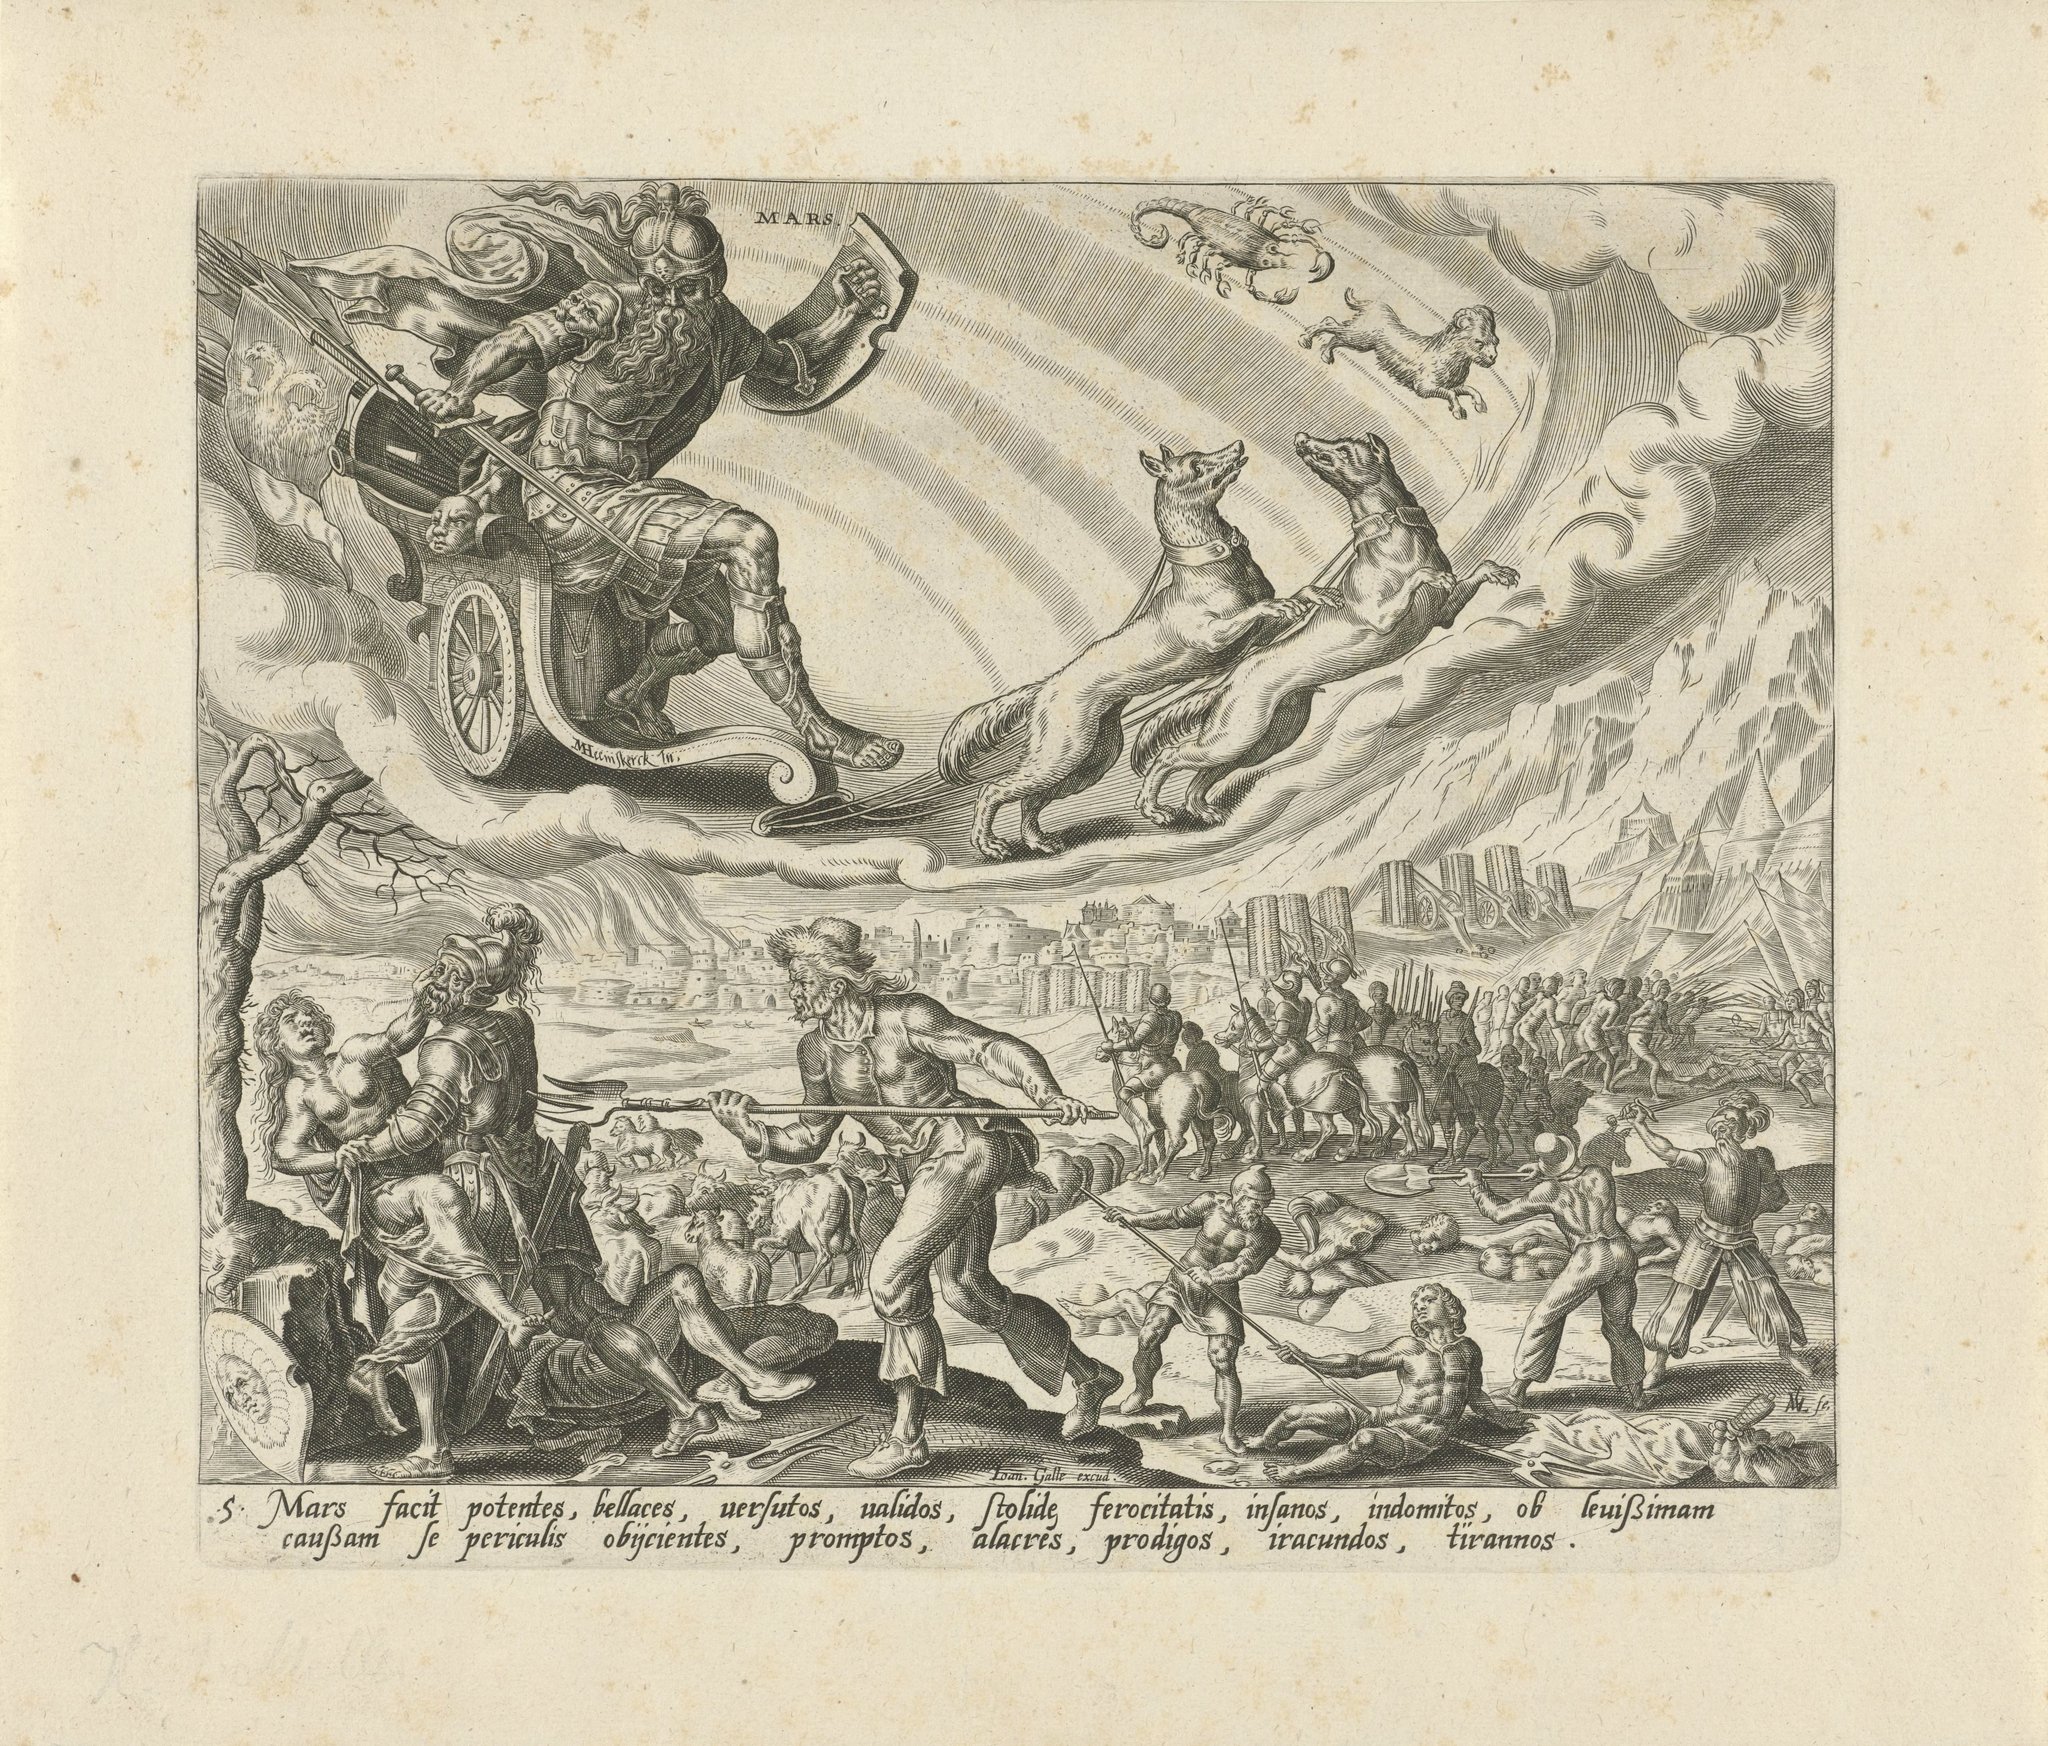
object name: print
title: De planeet Mars en zijn kinderen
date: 1566-1570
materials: paper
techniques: engraving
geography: antwerp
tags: rape, violation, (personifications of the) planets with their 'children', so-called 'planetenkinder', accompanied by the corresponding zodiacal signs, horrors of war, fighting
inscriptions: collector's mark: Lugt 2228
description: Prent mogelijk gebruikt in: Speculum diversarum imaginum speculativarum a variis doctis adinventarum, atque ab insignibus pictoribus ac sculptoribus delineatarum. Antwerpen: Johannes Galle, 1638. Of in: Schabaelje, Jan Philipsz. Den grooten figver-bibel. Dat is een afbeeldingh en levendighe vertooningh, van alle de voornaemste historien (...) der gantscher Heyliger Schrift, in schoone copere figueren (...) verrijckt met leersame verclaeringhen over de selve figueren. Alkmaar: Simon Cornelisz Brekegeest, Amsterdam: Jan Philipsz. Schabaelje, 1646.